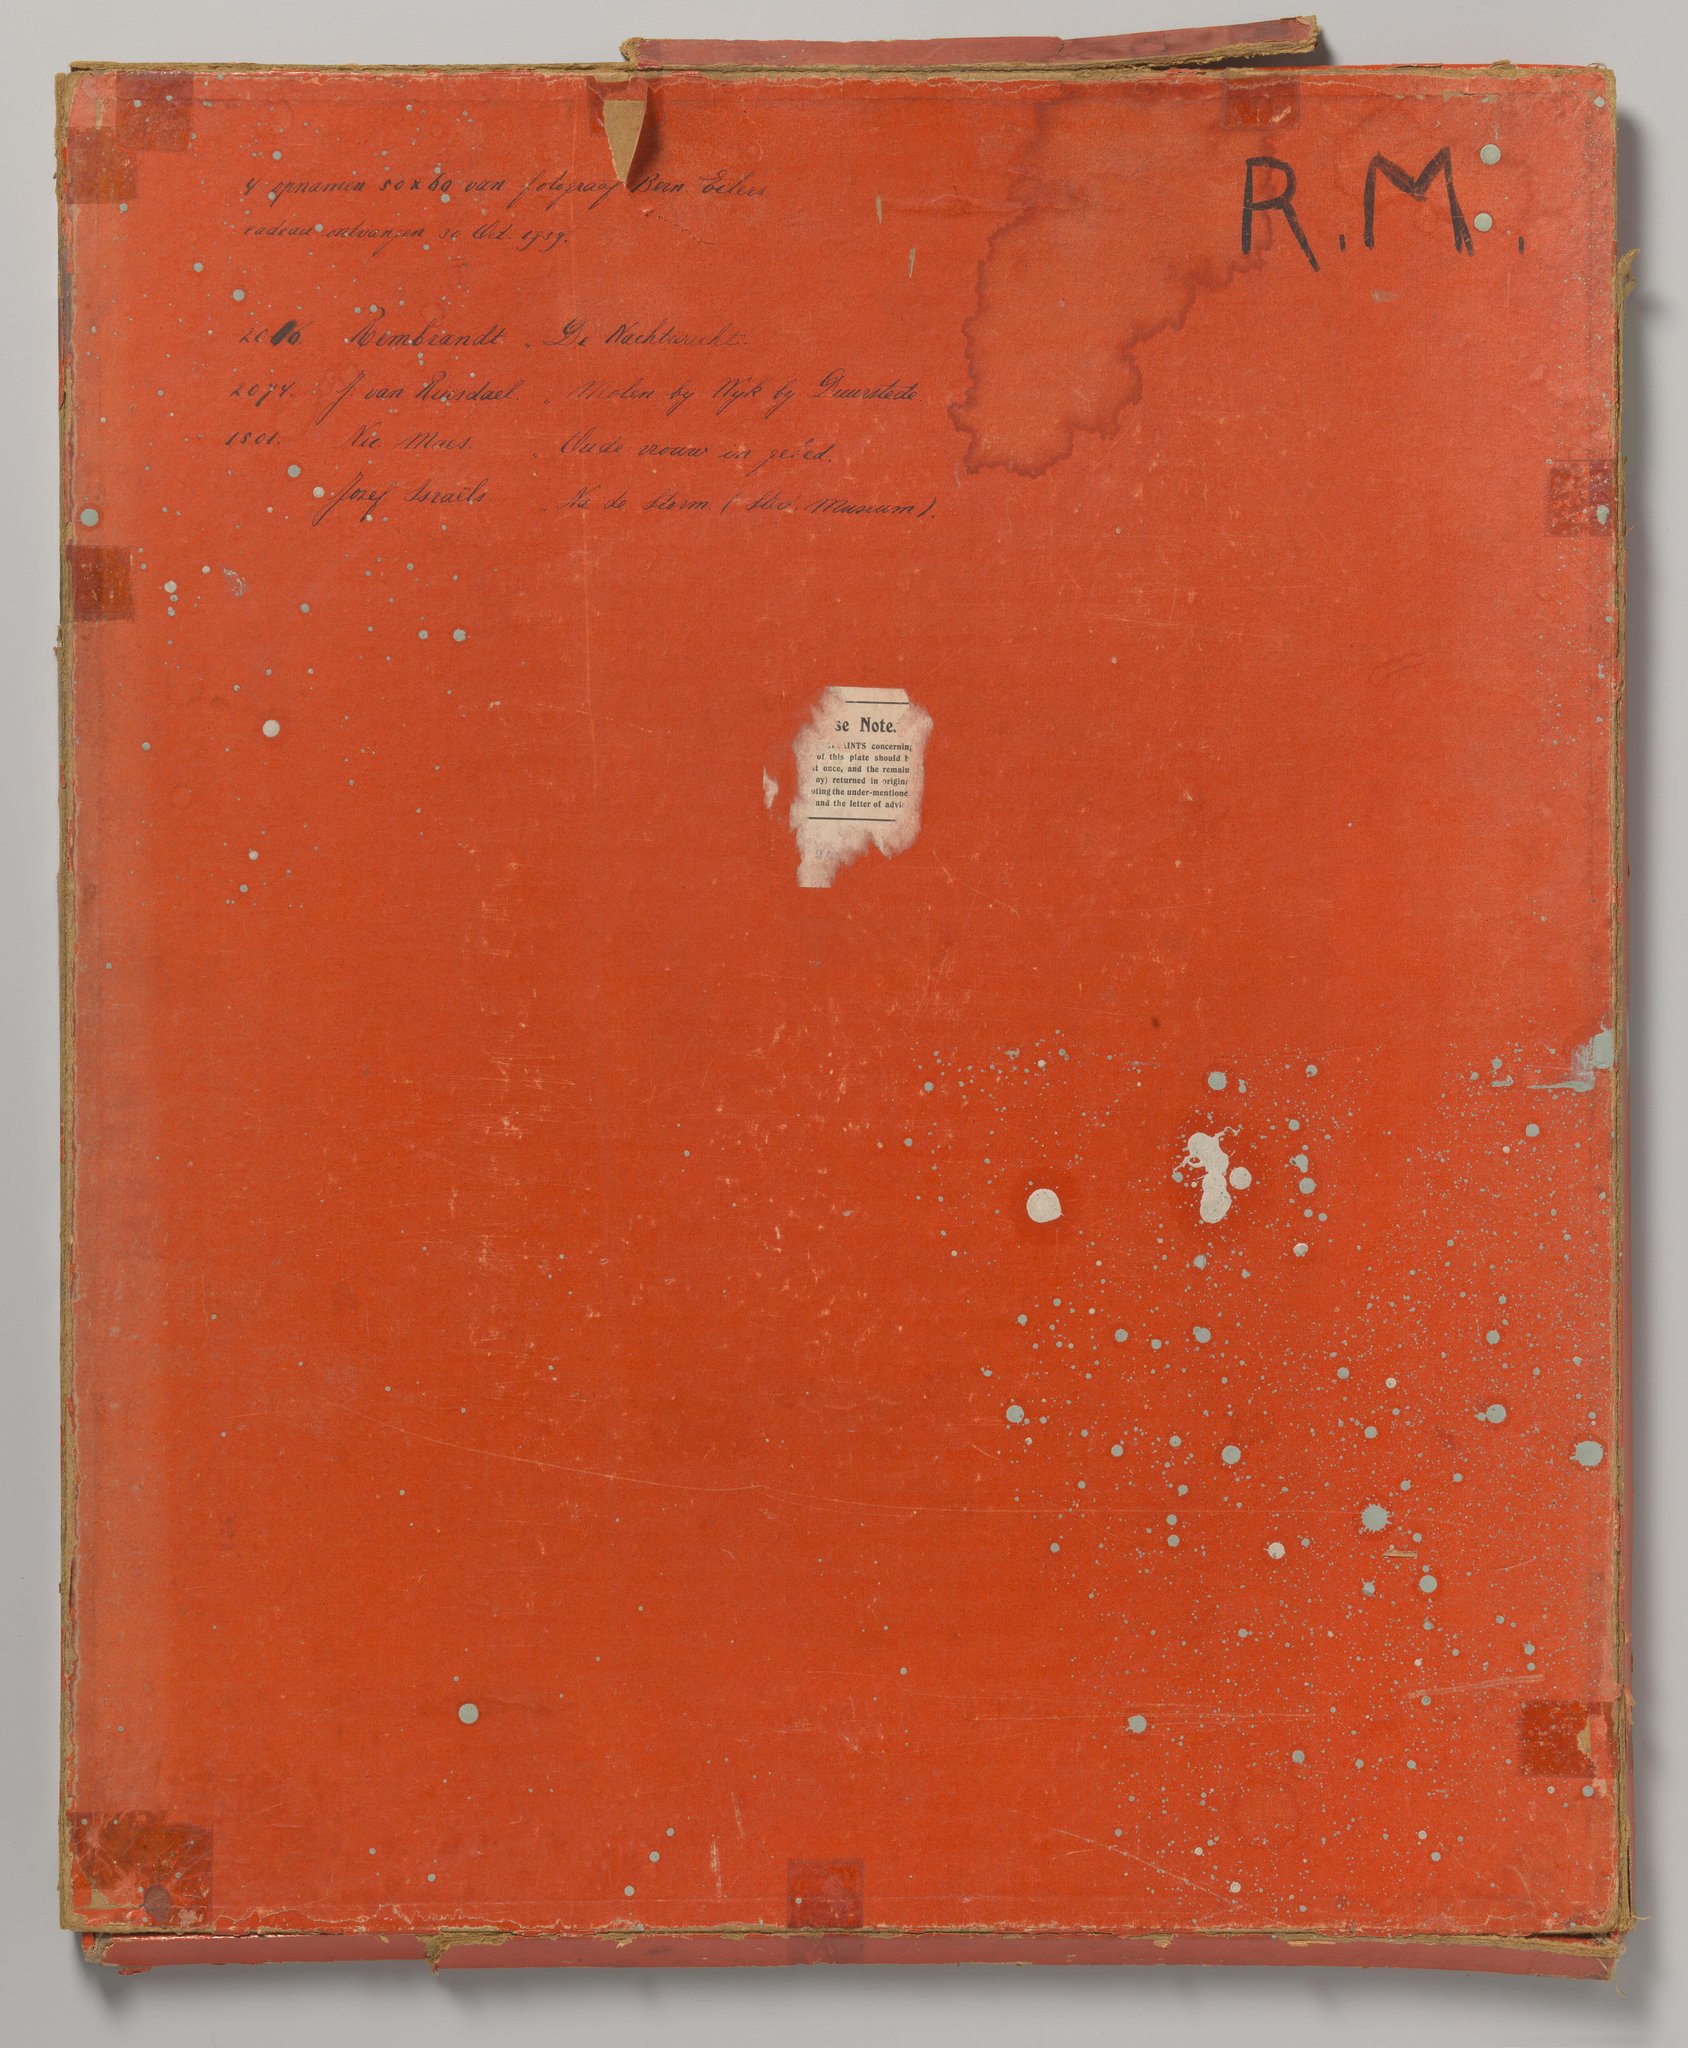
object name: box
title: Originele oranje kartonnen doos behorend bij 5 grote glasnegatieven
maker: Anonymous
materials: cardboard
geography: amsterdam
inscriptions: annotation: ‘4 opnamen 50 x 60 van fotograaf Bern. Eilers/ cadeau ontvangen 30 Oct. 1939/ 2016 Rembrandt. De Nachtwacht/ 2074 J. van Ruisdael Molen bij Wijk bij Duurstede/ 1501 Nic Maes Oude vrouw in gebed Jozef Israëls Na de Storm (Stedelijk Museum)’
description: Originele doos behorend bij vijf grote glasnegatieven: fotoreproducties schilderijen in de collecties van Rijksmuseum en Stedelijk Museum en van een reliëf in de collectie van het Rijksmuseum. Vier glasnegatieven werden aan het Rijksmuseum geschonken door fotograaf Bernard Eilers op 30 oktober 1939.